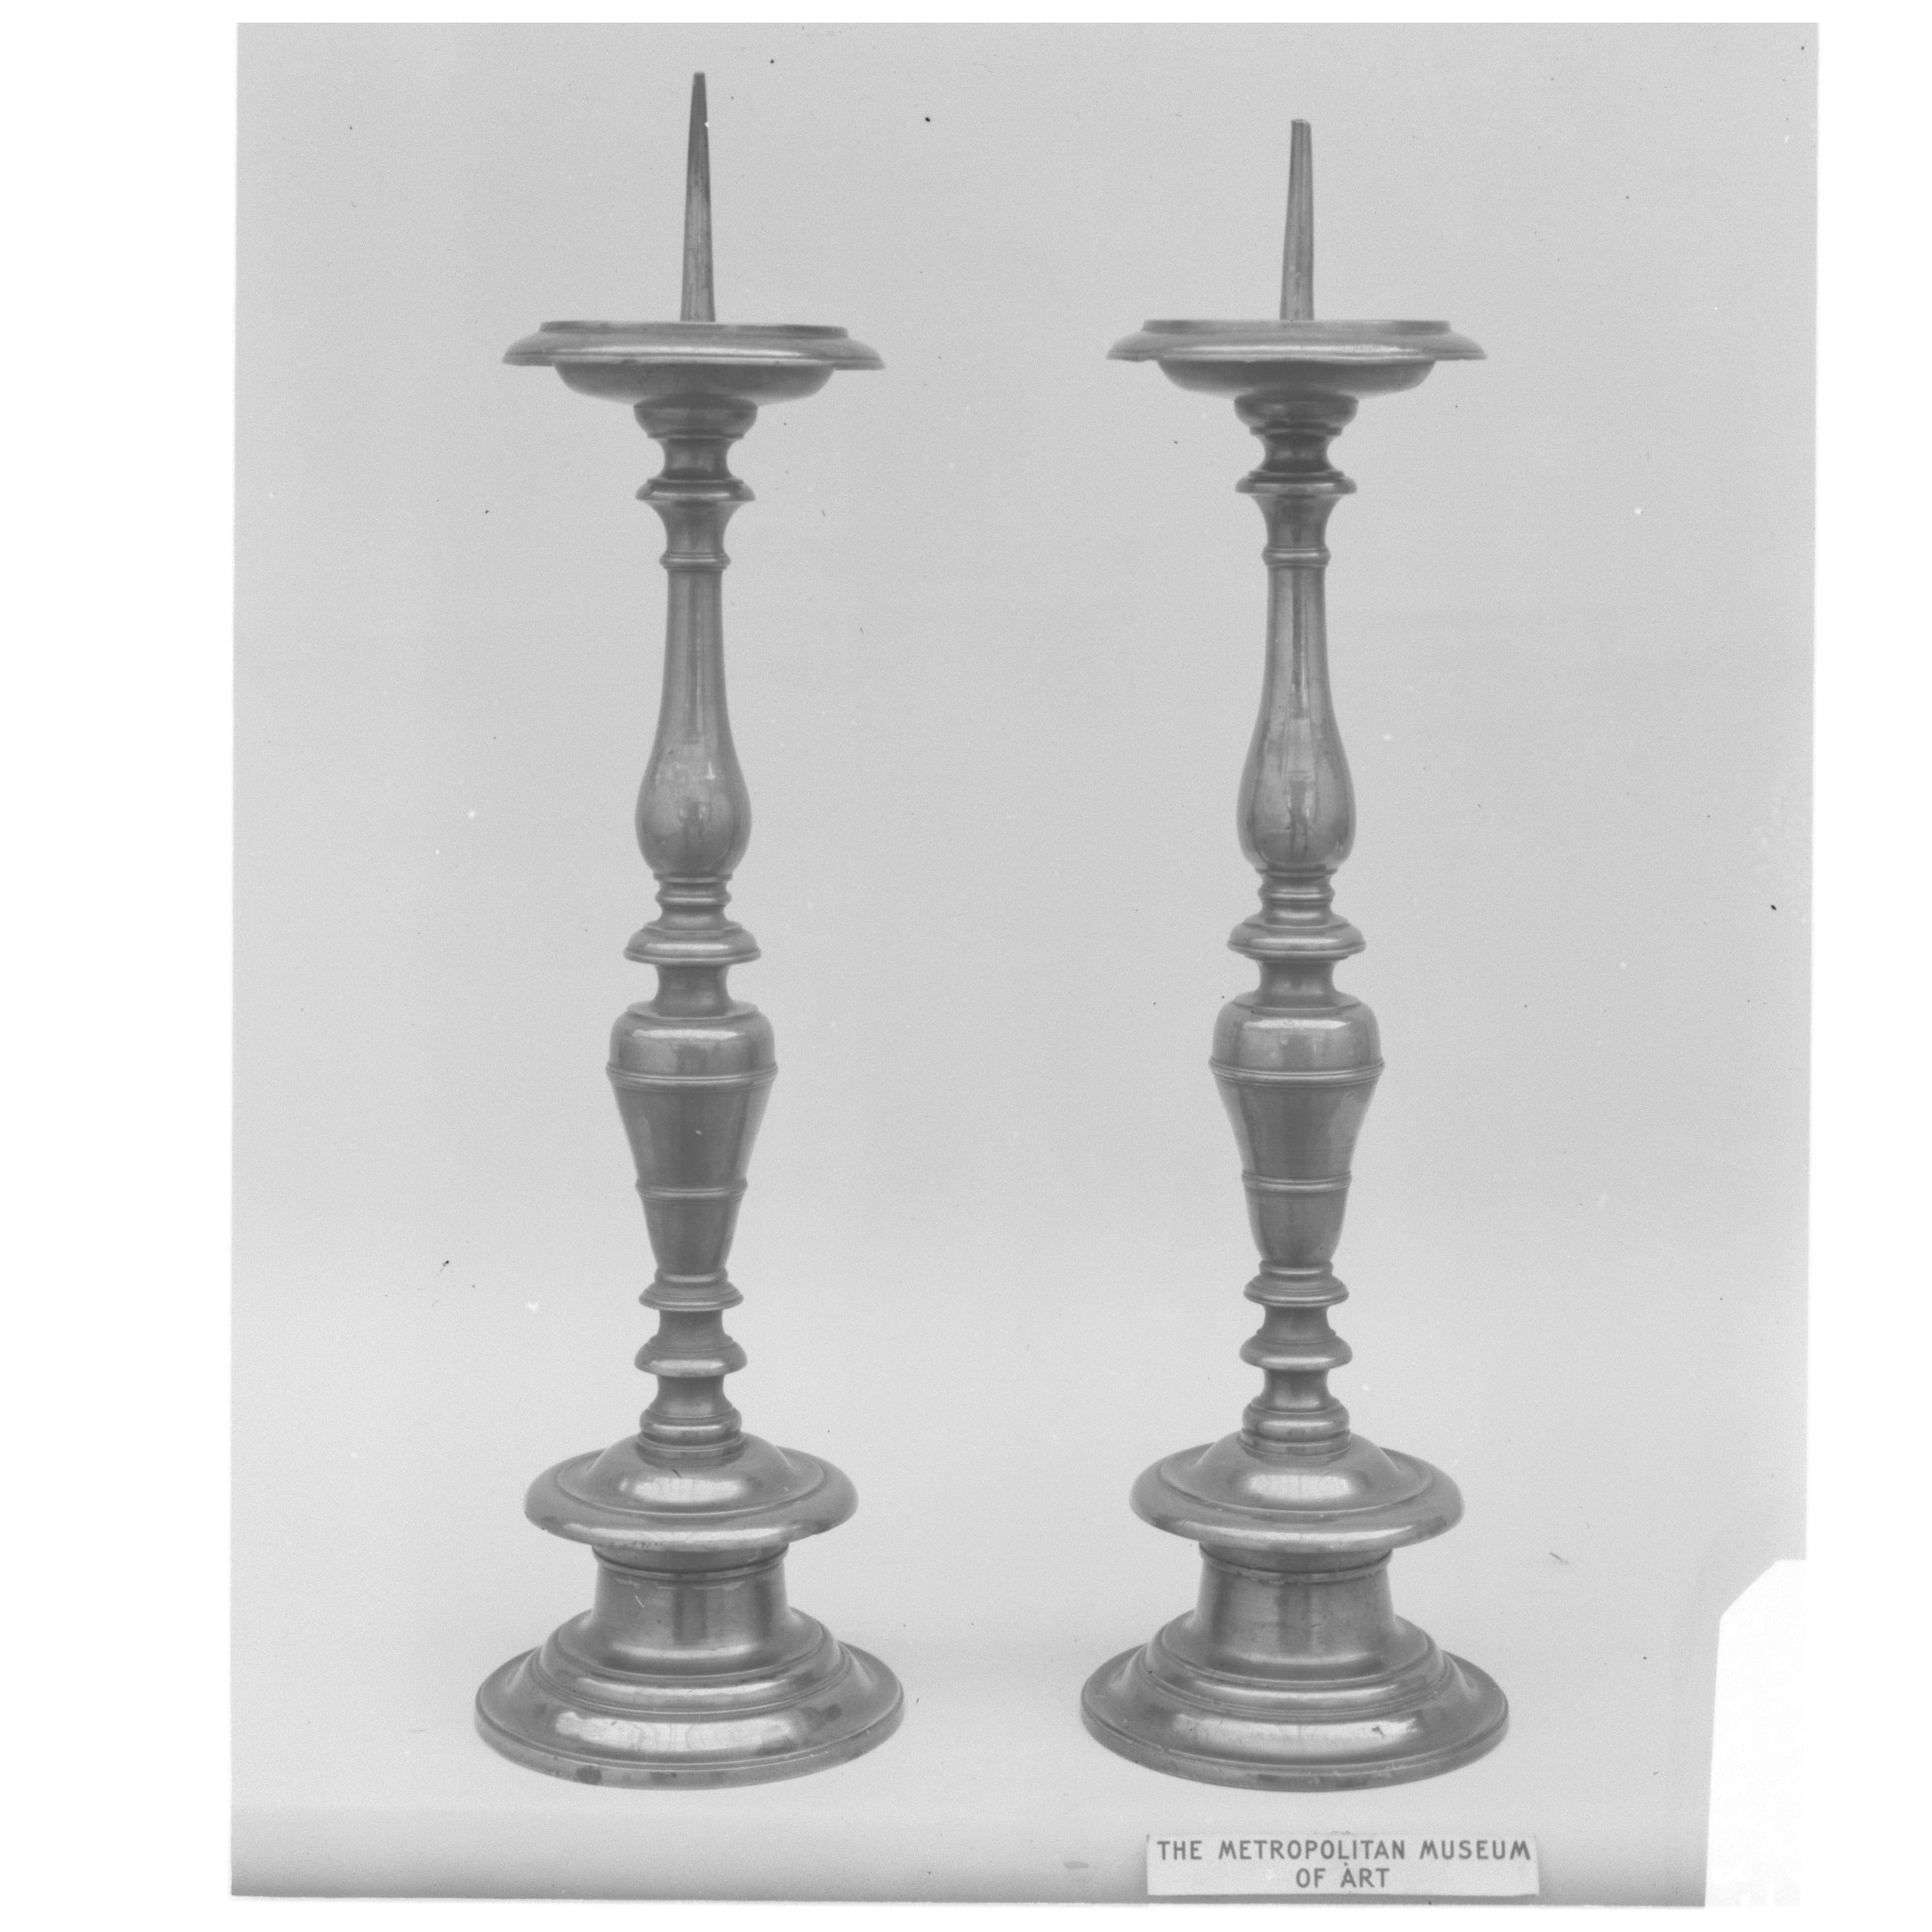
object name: candlestick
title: Pair of candlesticks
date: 1601-1700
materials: brass